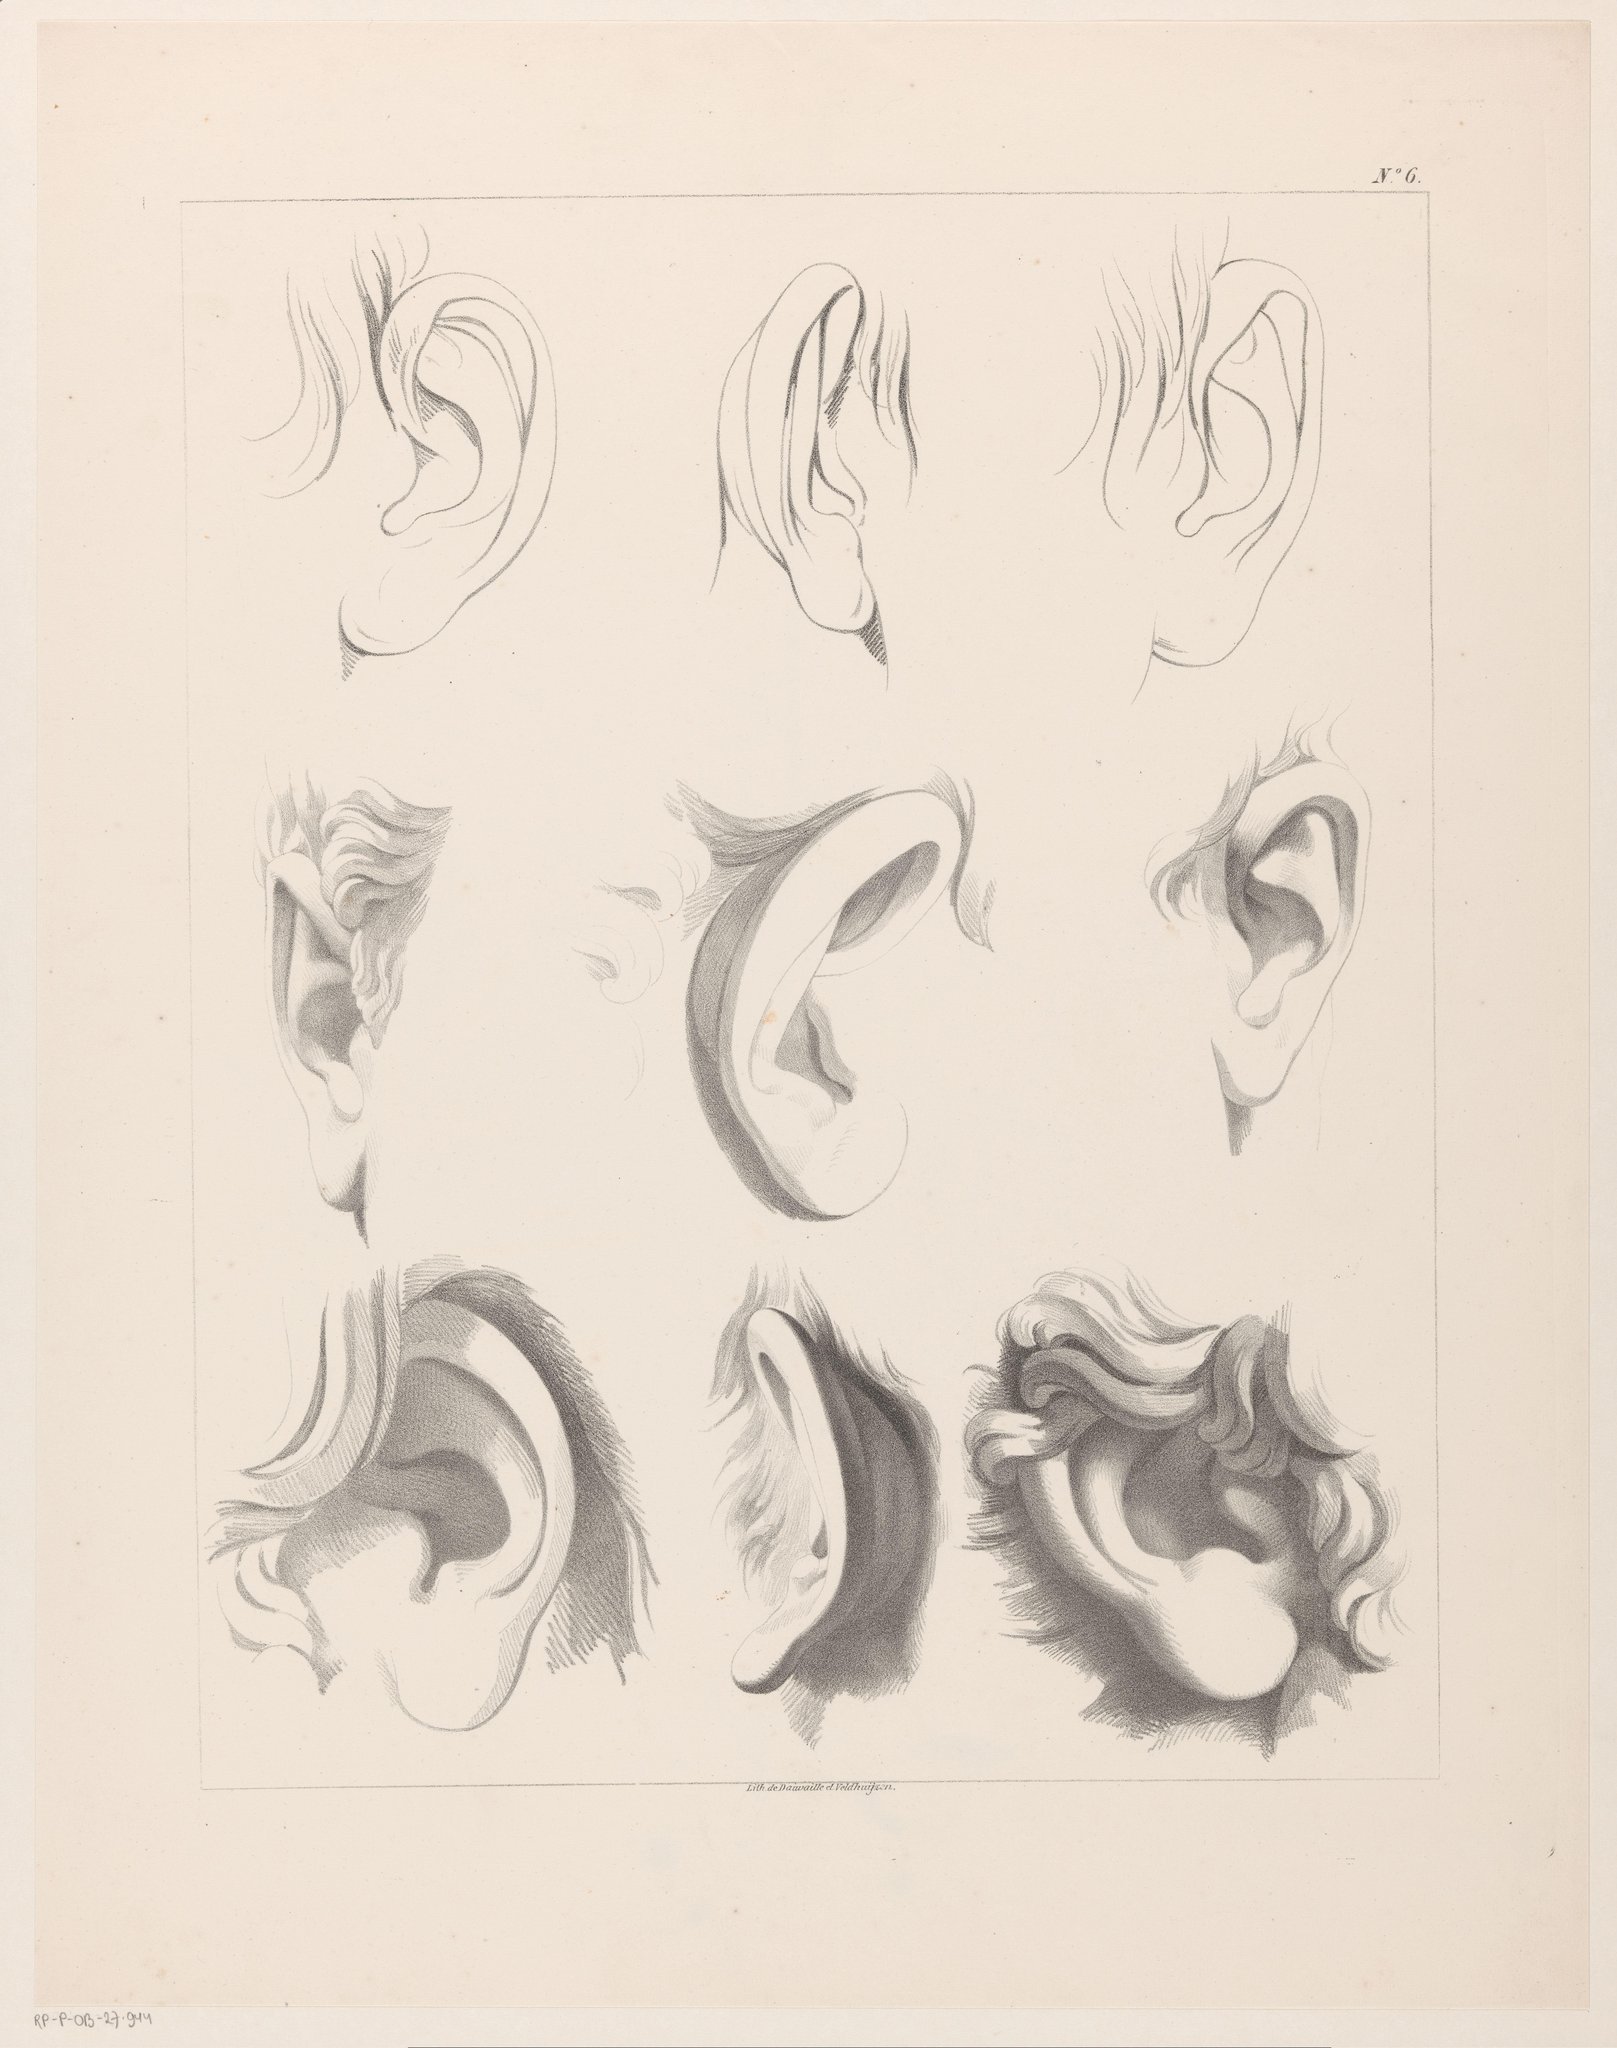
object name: print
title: Negen oren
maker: jean augustin daiwaille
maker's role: draughtsman, print maker, printer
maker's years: 1786-1850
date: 1820-1833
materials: paper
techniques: lithograph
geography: amsterdam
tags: ears (+ sideview, profile), ears (+ front view), ears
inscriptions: collector's mark: Lugt 2228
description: De oren zijn van verschillende aanzichten afgebeeld. Het oor rechtsonder is omkranst met gekrulde lokken haar. Genummerd rechtsboven: No. 6.